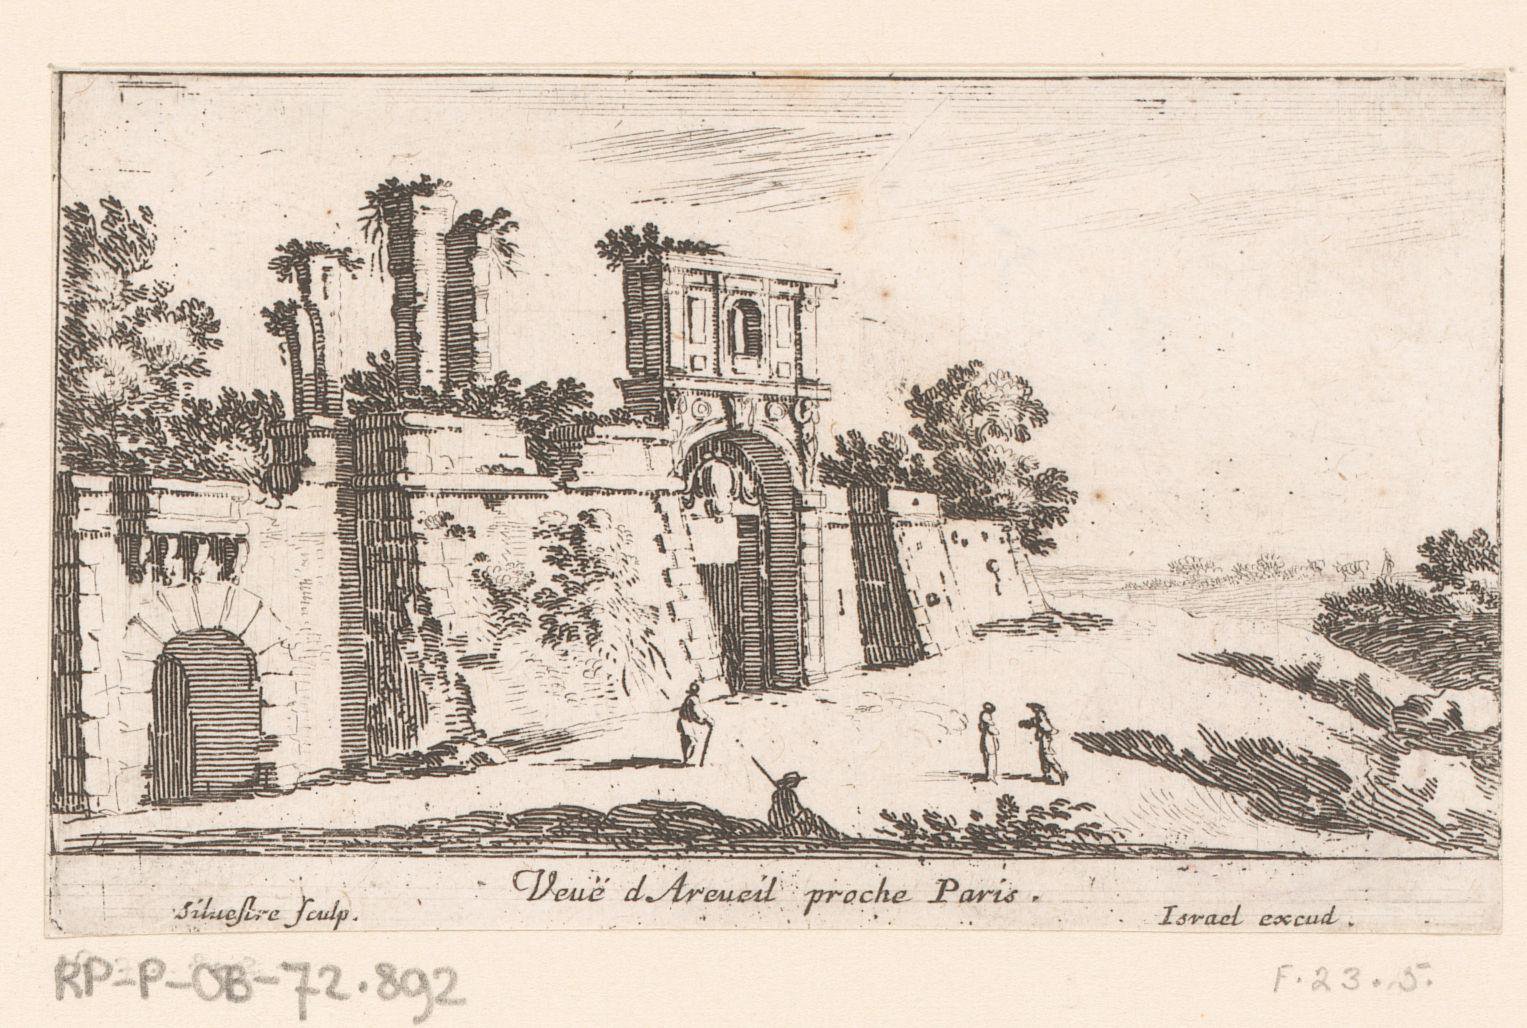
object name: print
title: Vues d'Italie et de France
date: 1631-1661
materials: paper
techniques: etching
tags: city-view, and landscape with man-made constructions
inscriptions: collector's mark: Lugt 240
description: Prent maakt deel uit van een ongenummerde serie van negen prenten.